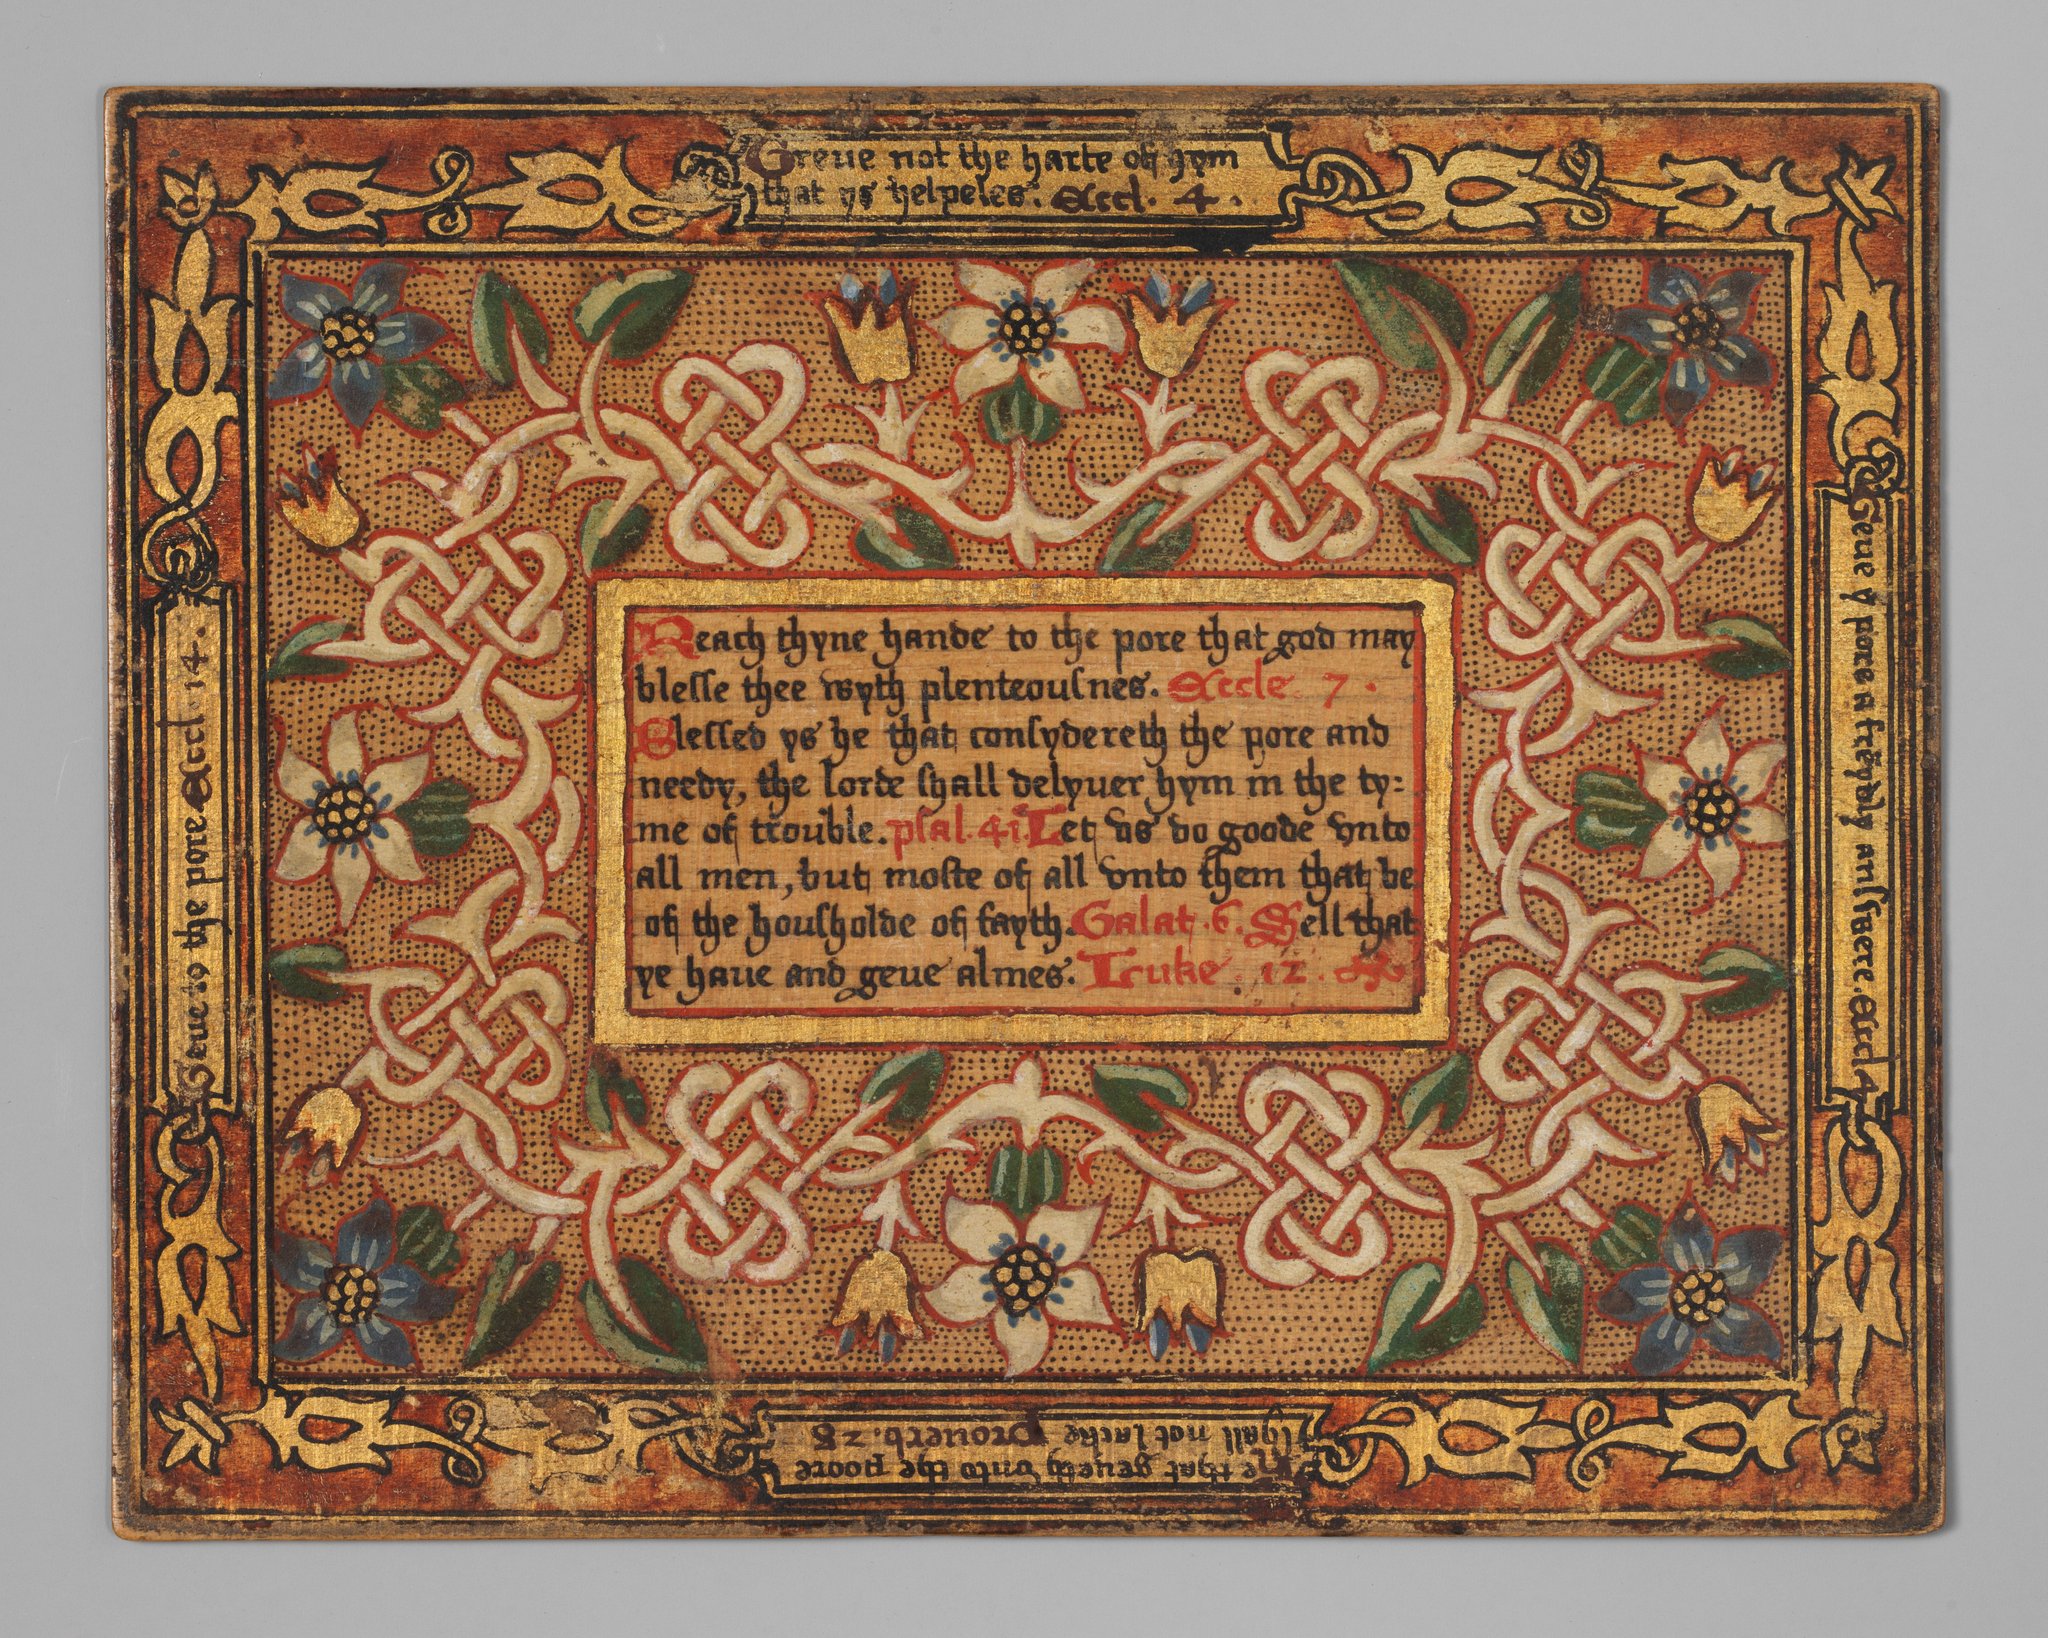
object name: trencher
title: Trencher with quotation from The Governance of Virtue (1566) (one of a set)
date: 1601-1633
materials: wood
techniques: gilding, painting